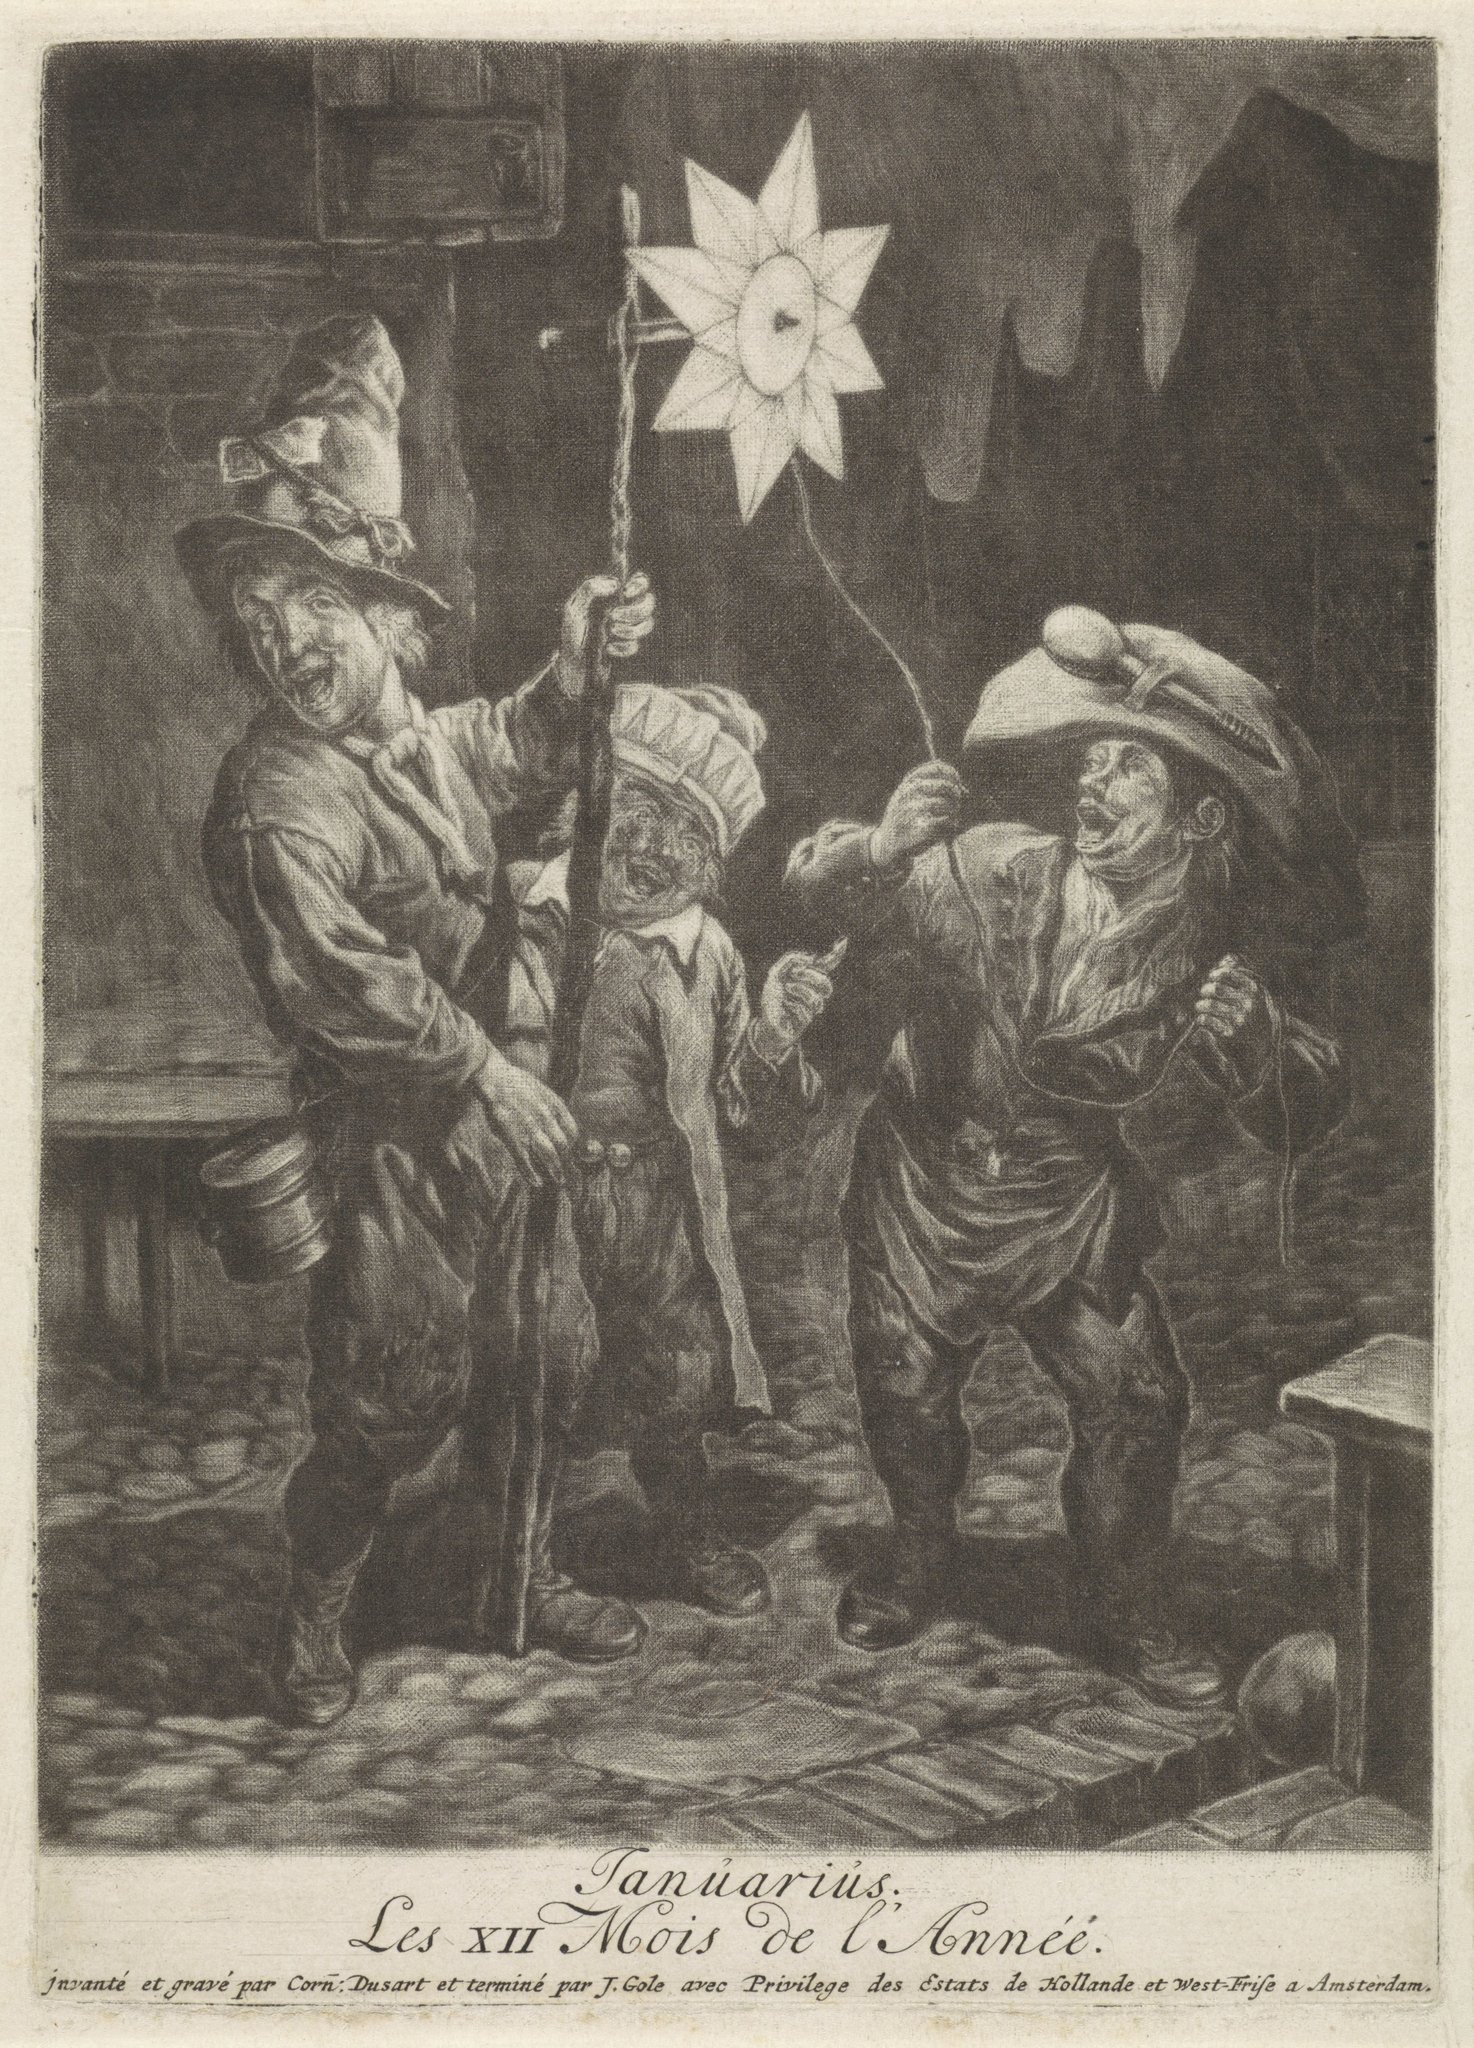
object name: titelprent, frontispice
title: De twaalf maanden van het jaar, "Les XII Mois de l'Année"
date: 1679-1704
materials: paper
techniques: engraving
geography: amsterdam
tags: january and its 'labours', twelfth night, usually falling on the eve of january 6, stars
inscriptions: collector's mark: Lugt 2228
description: Nachtgezicht in een stad met drie kinderen die Driekoningen vieren. Een van de kinderen houdt een ster op een stok omhoog. De prent is de titelprent van een serie van twaalf prenten met de twaalf maanden van het jaar.